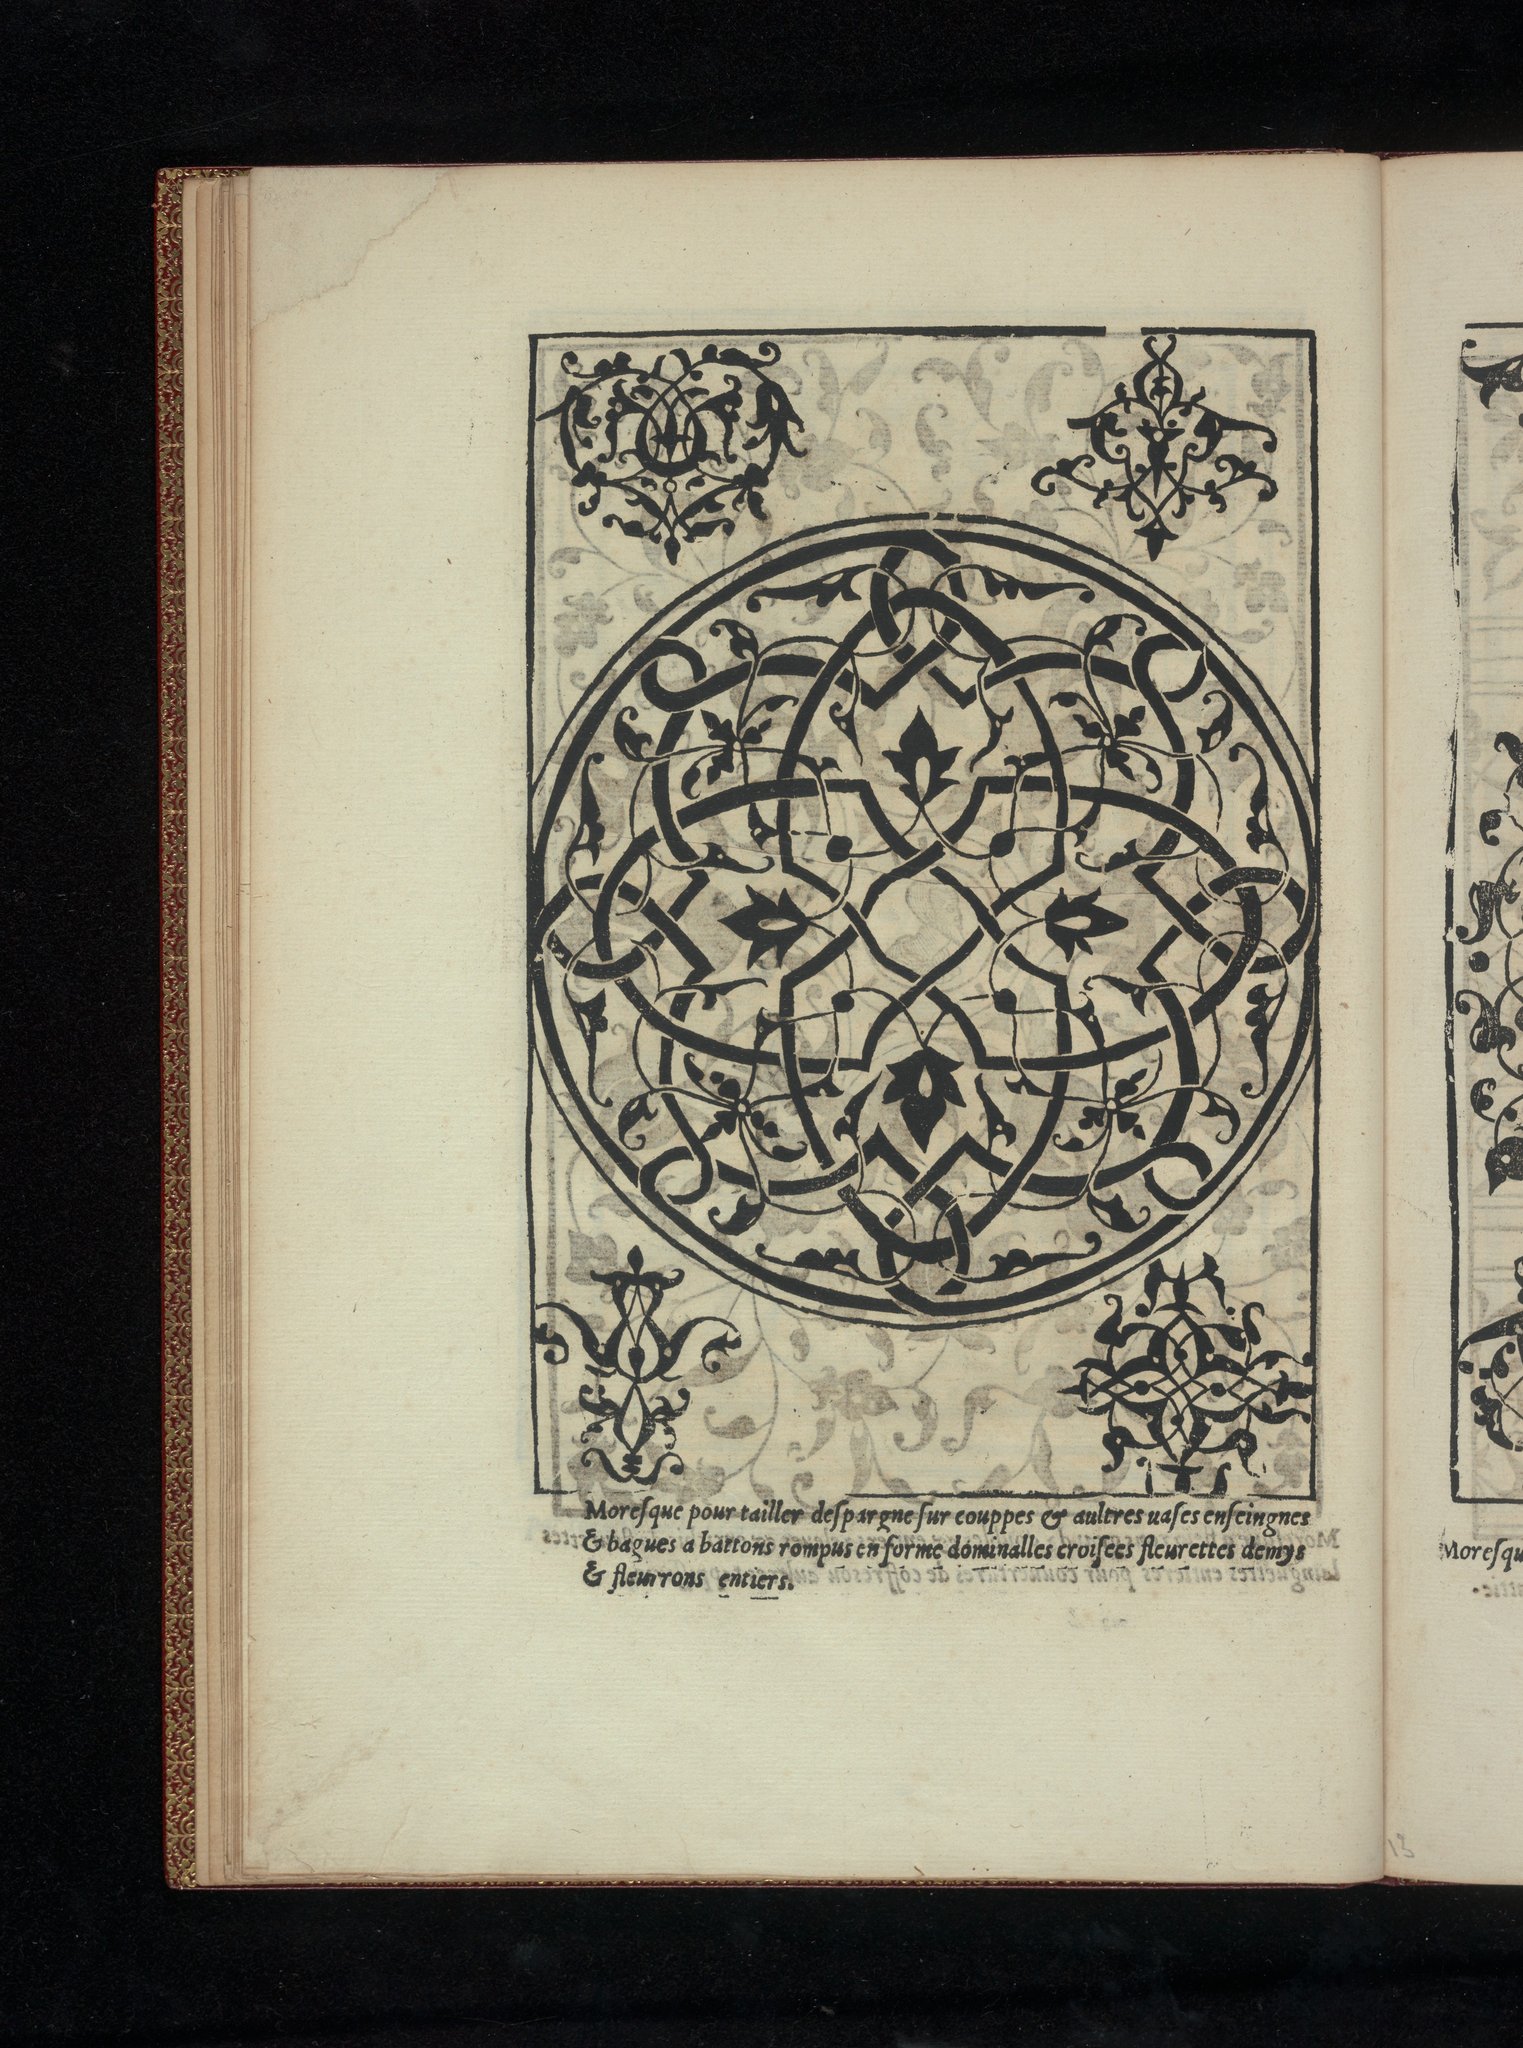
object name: book print ornament architecture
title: Livre de Moresques, page 13 (verso)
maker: francesco di pellegrino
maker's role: artist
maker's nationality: italian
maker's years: 1525-1552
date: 1546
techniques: woodcut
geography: france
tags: ornament